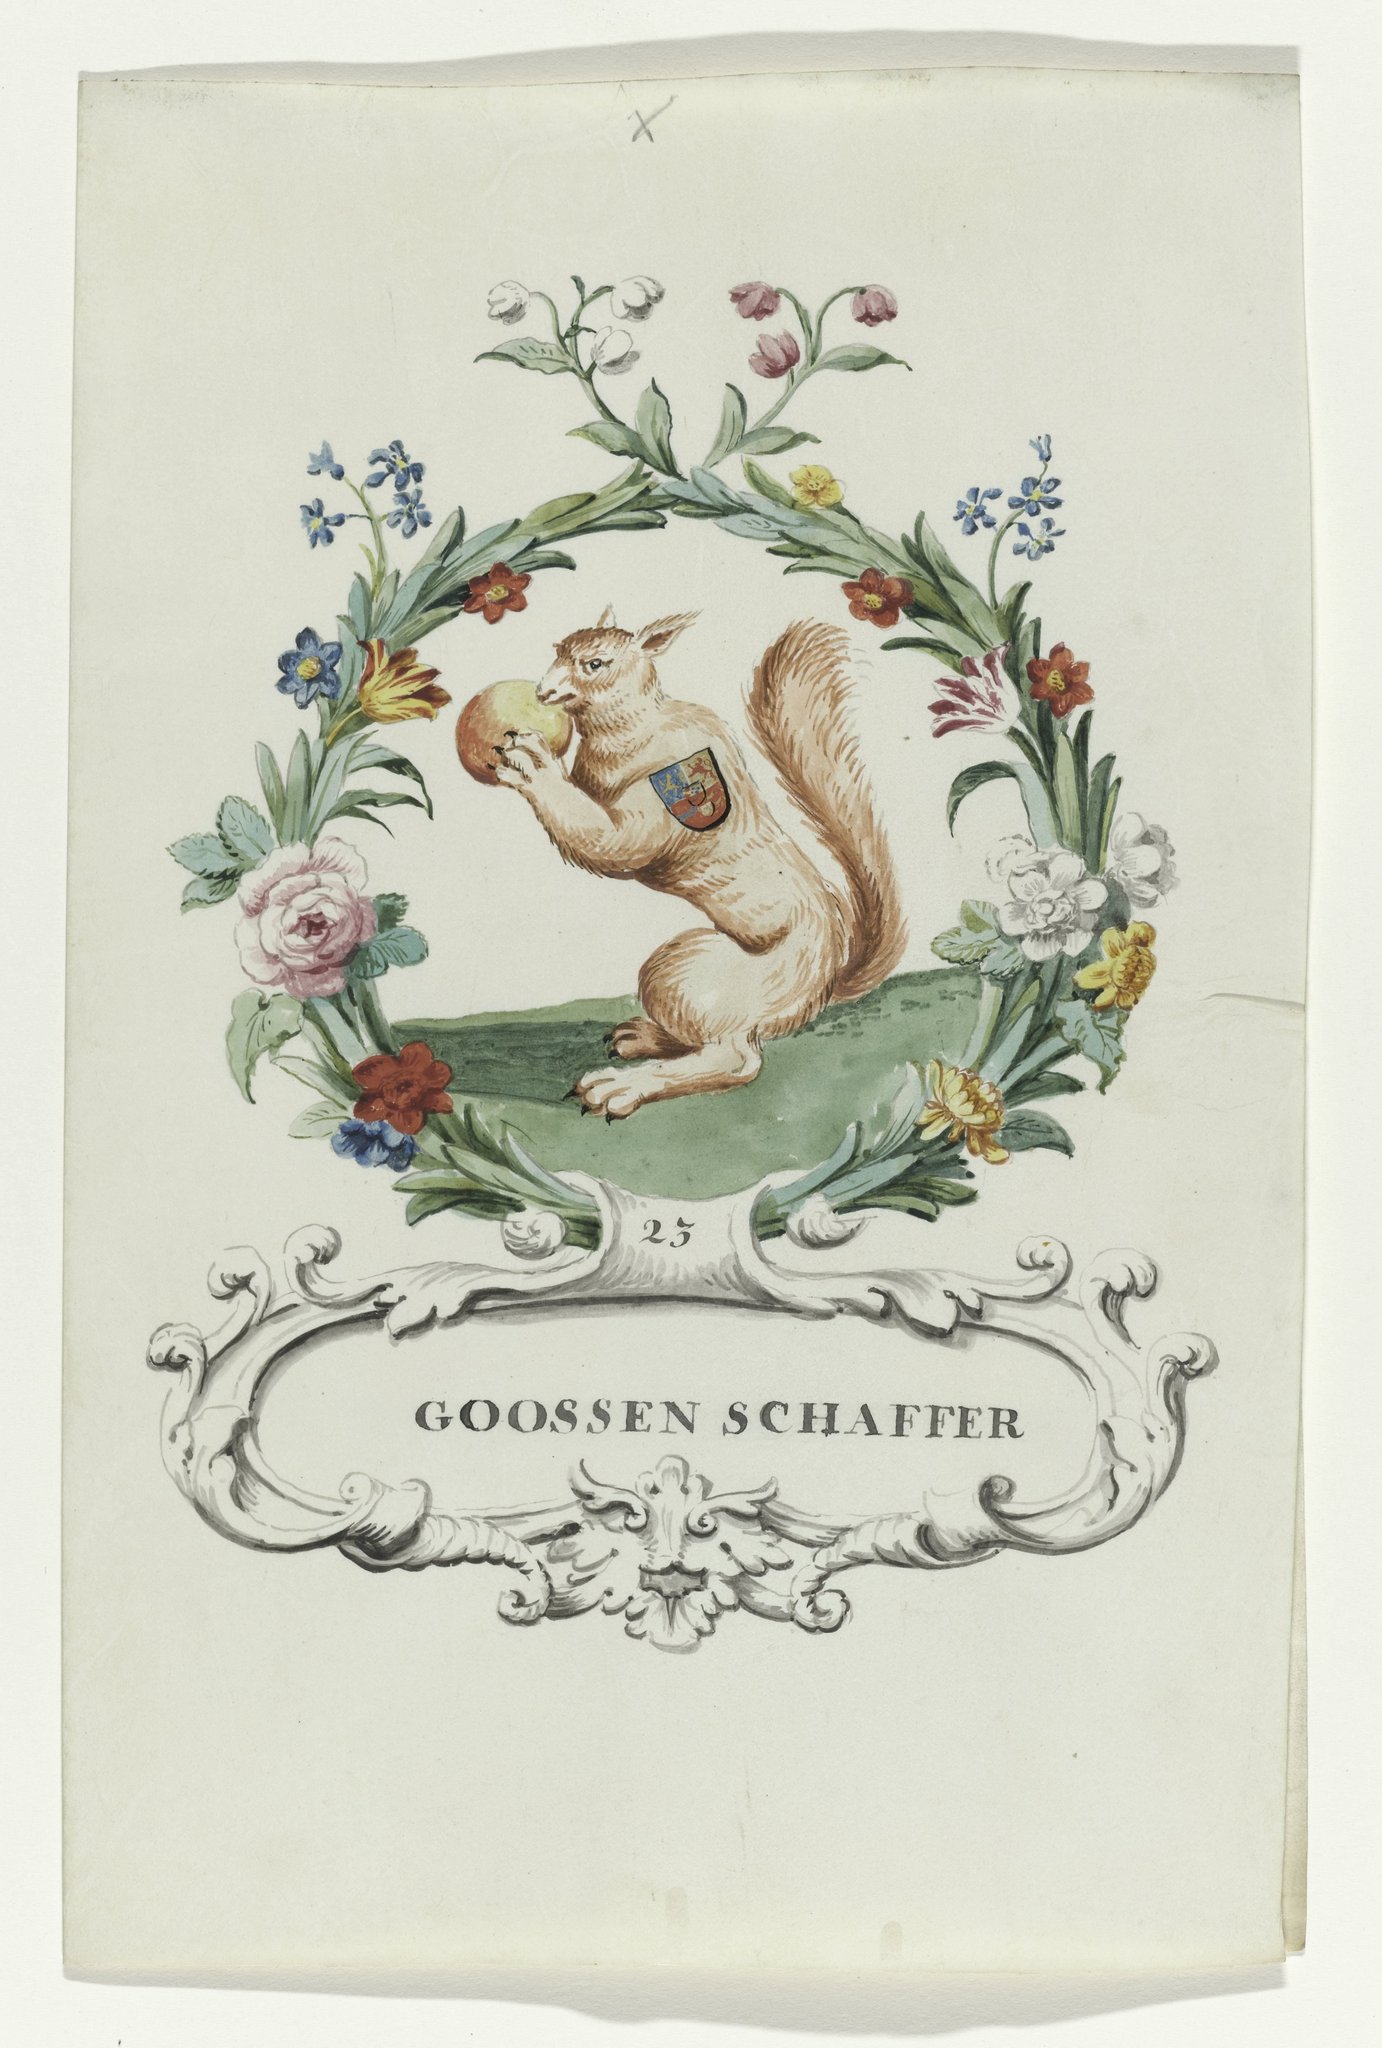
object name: cartoon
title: Spotprent van Goossen Schaffer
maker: Anonymous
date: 1710-1720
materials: ink, parchment, watercolor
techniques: brush, pen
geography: netherlands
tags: the hague, johan van oldenbarnevelt, caricatures (human types), bad, corrupt judge, rodents: squirrel, political caricatures and satires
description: Spotprent van Goossen Schaffer, rechter van Van Oldenbarnevelt; eekhoorn bijtend in oranje-appel. Op linkerschouder wapen. In krans van bloemen en bladeren, daaronder cartouche met naam en nummer 25. Behorende bij serie aquarellen in boek.